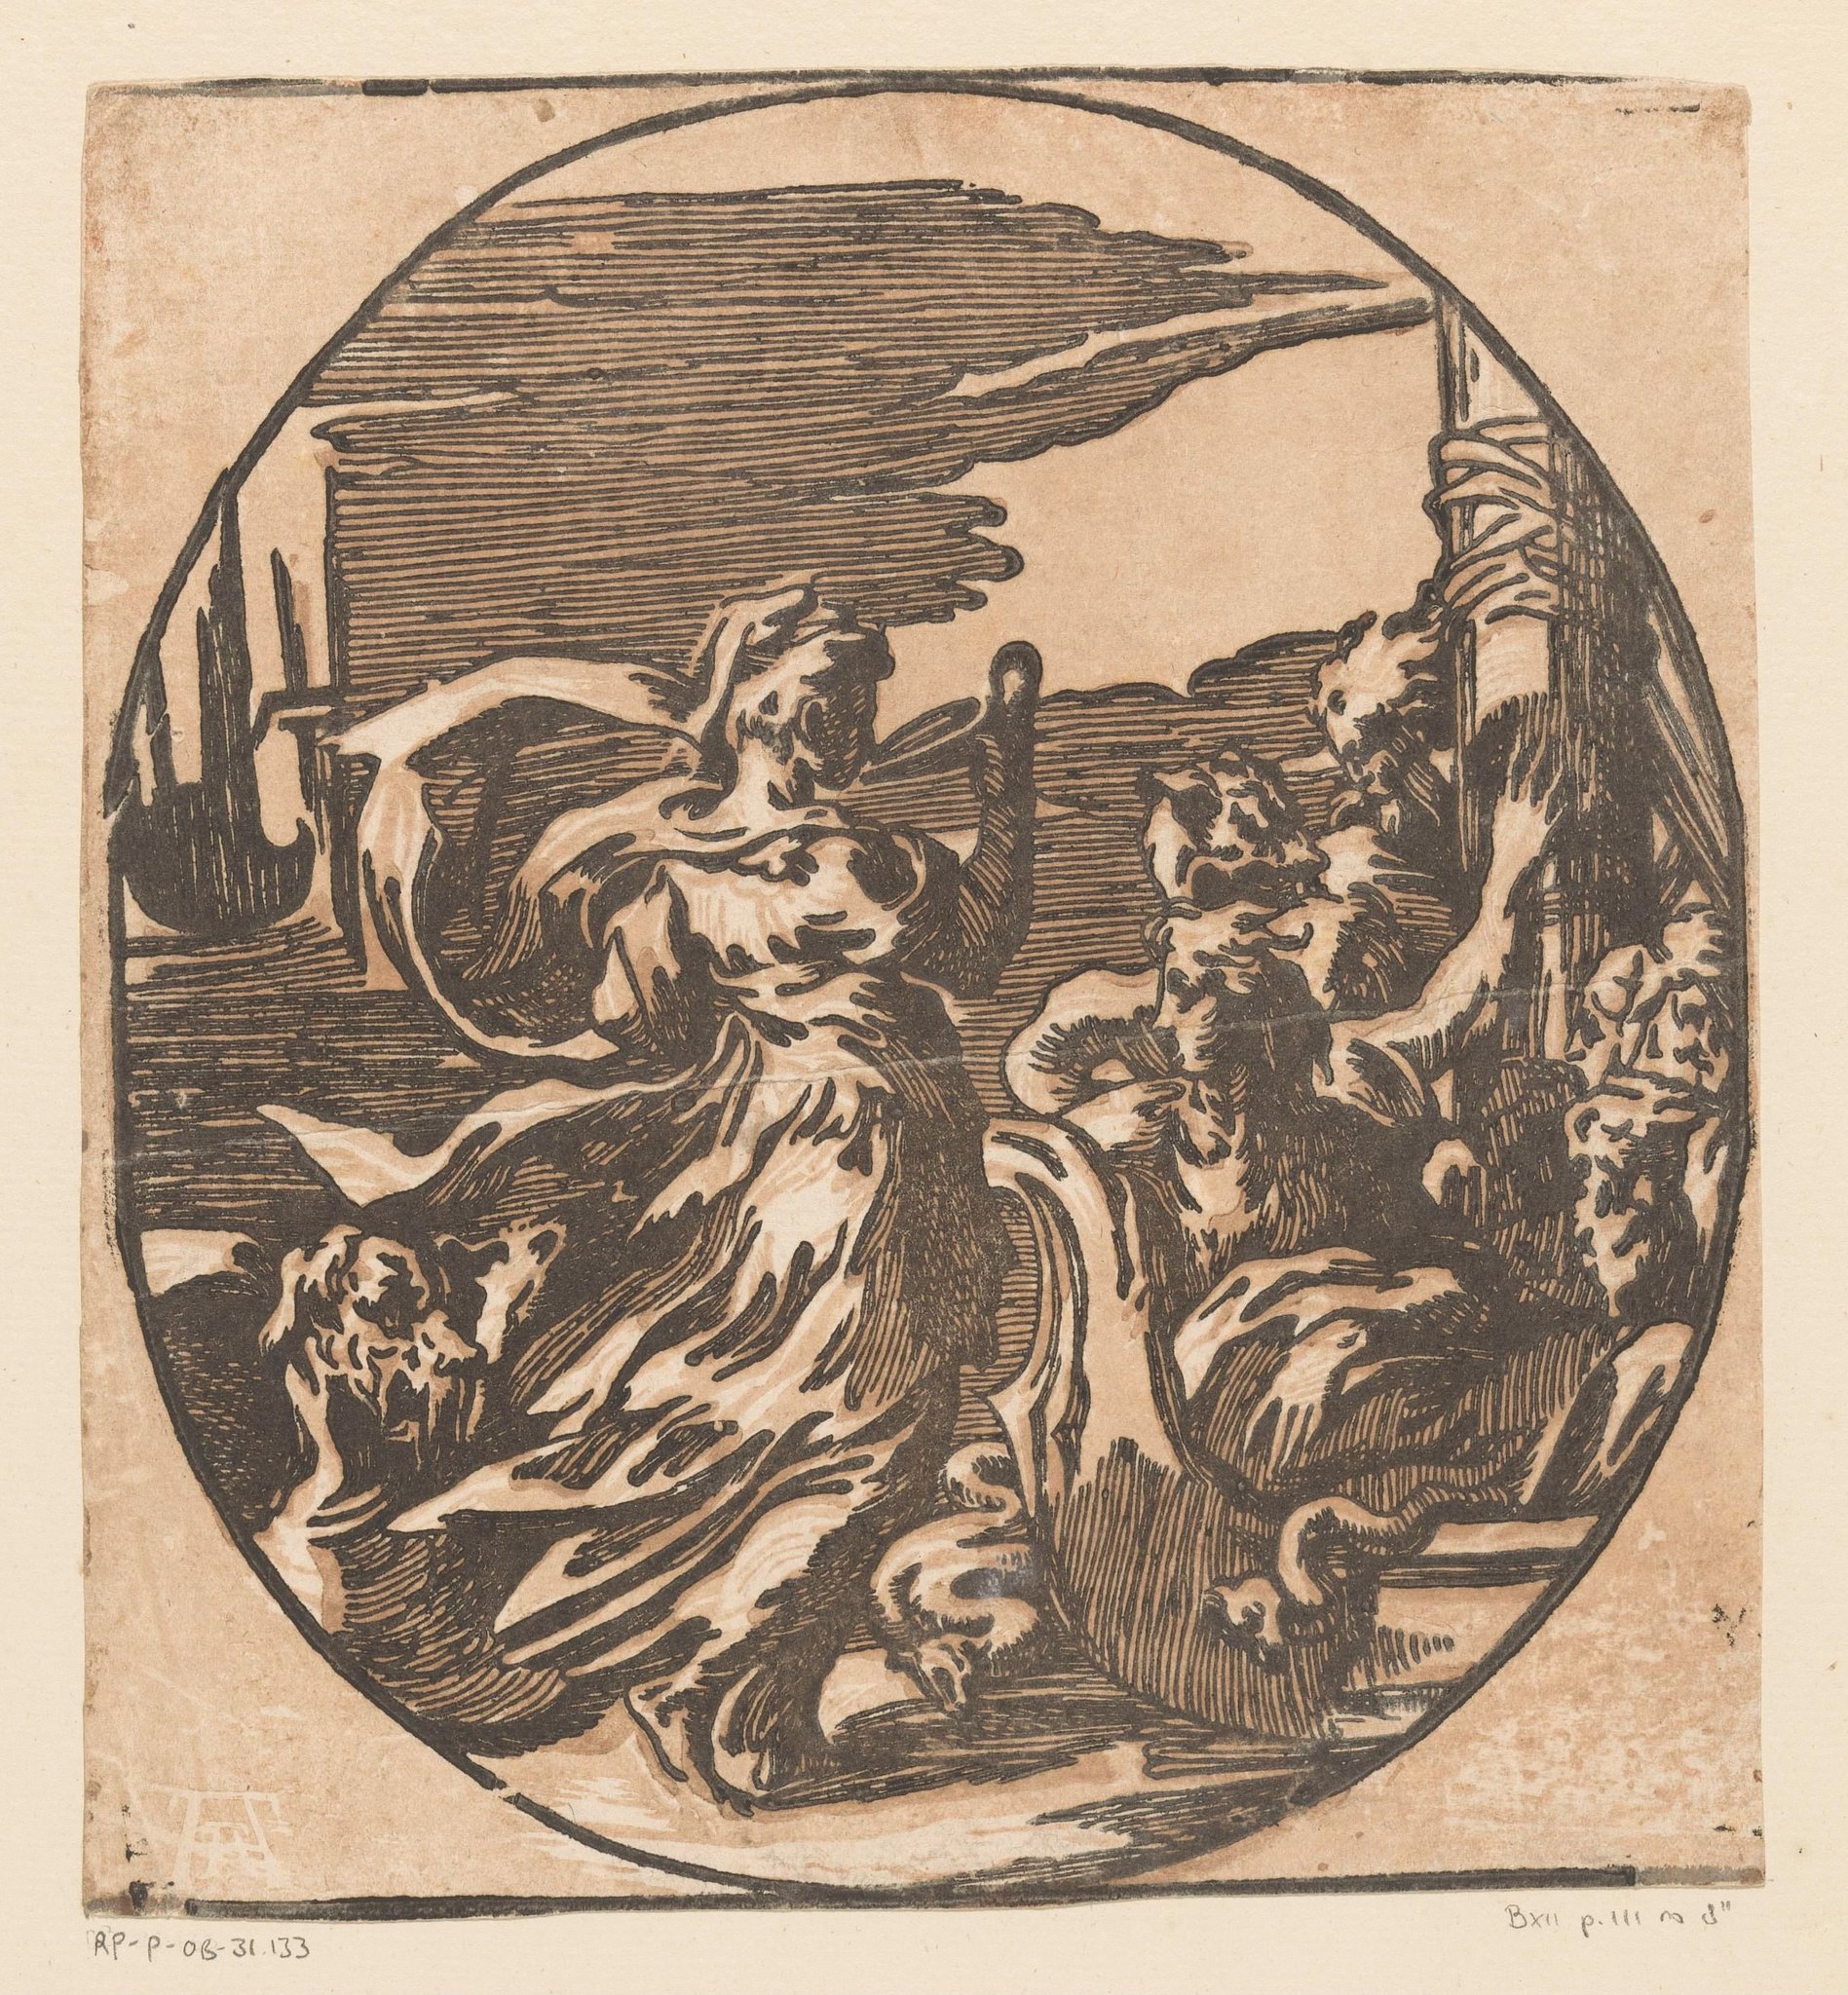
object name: print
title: Circe drinkend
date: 1568-1629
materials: paper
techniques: woodcut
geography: italy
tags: circe, ulysses on the island of circe (homer, odyssey x), drinking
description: Circe drinkend uit een kom en rechts de mannen van Odysseus op een schip.